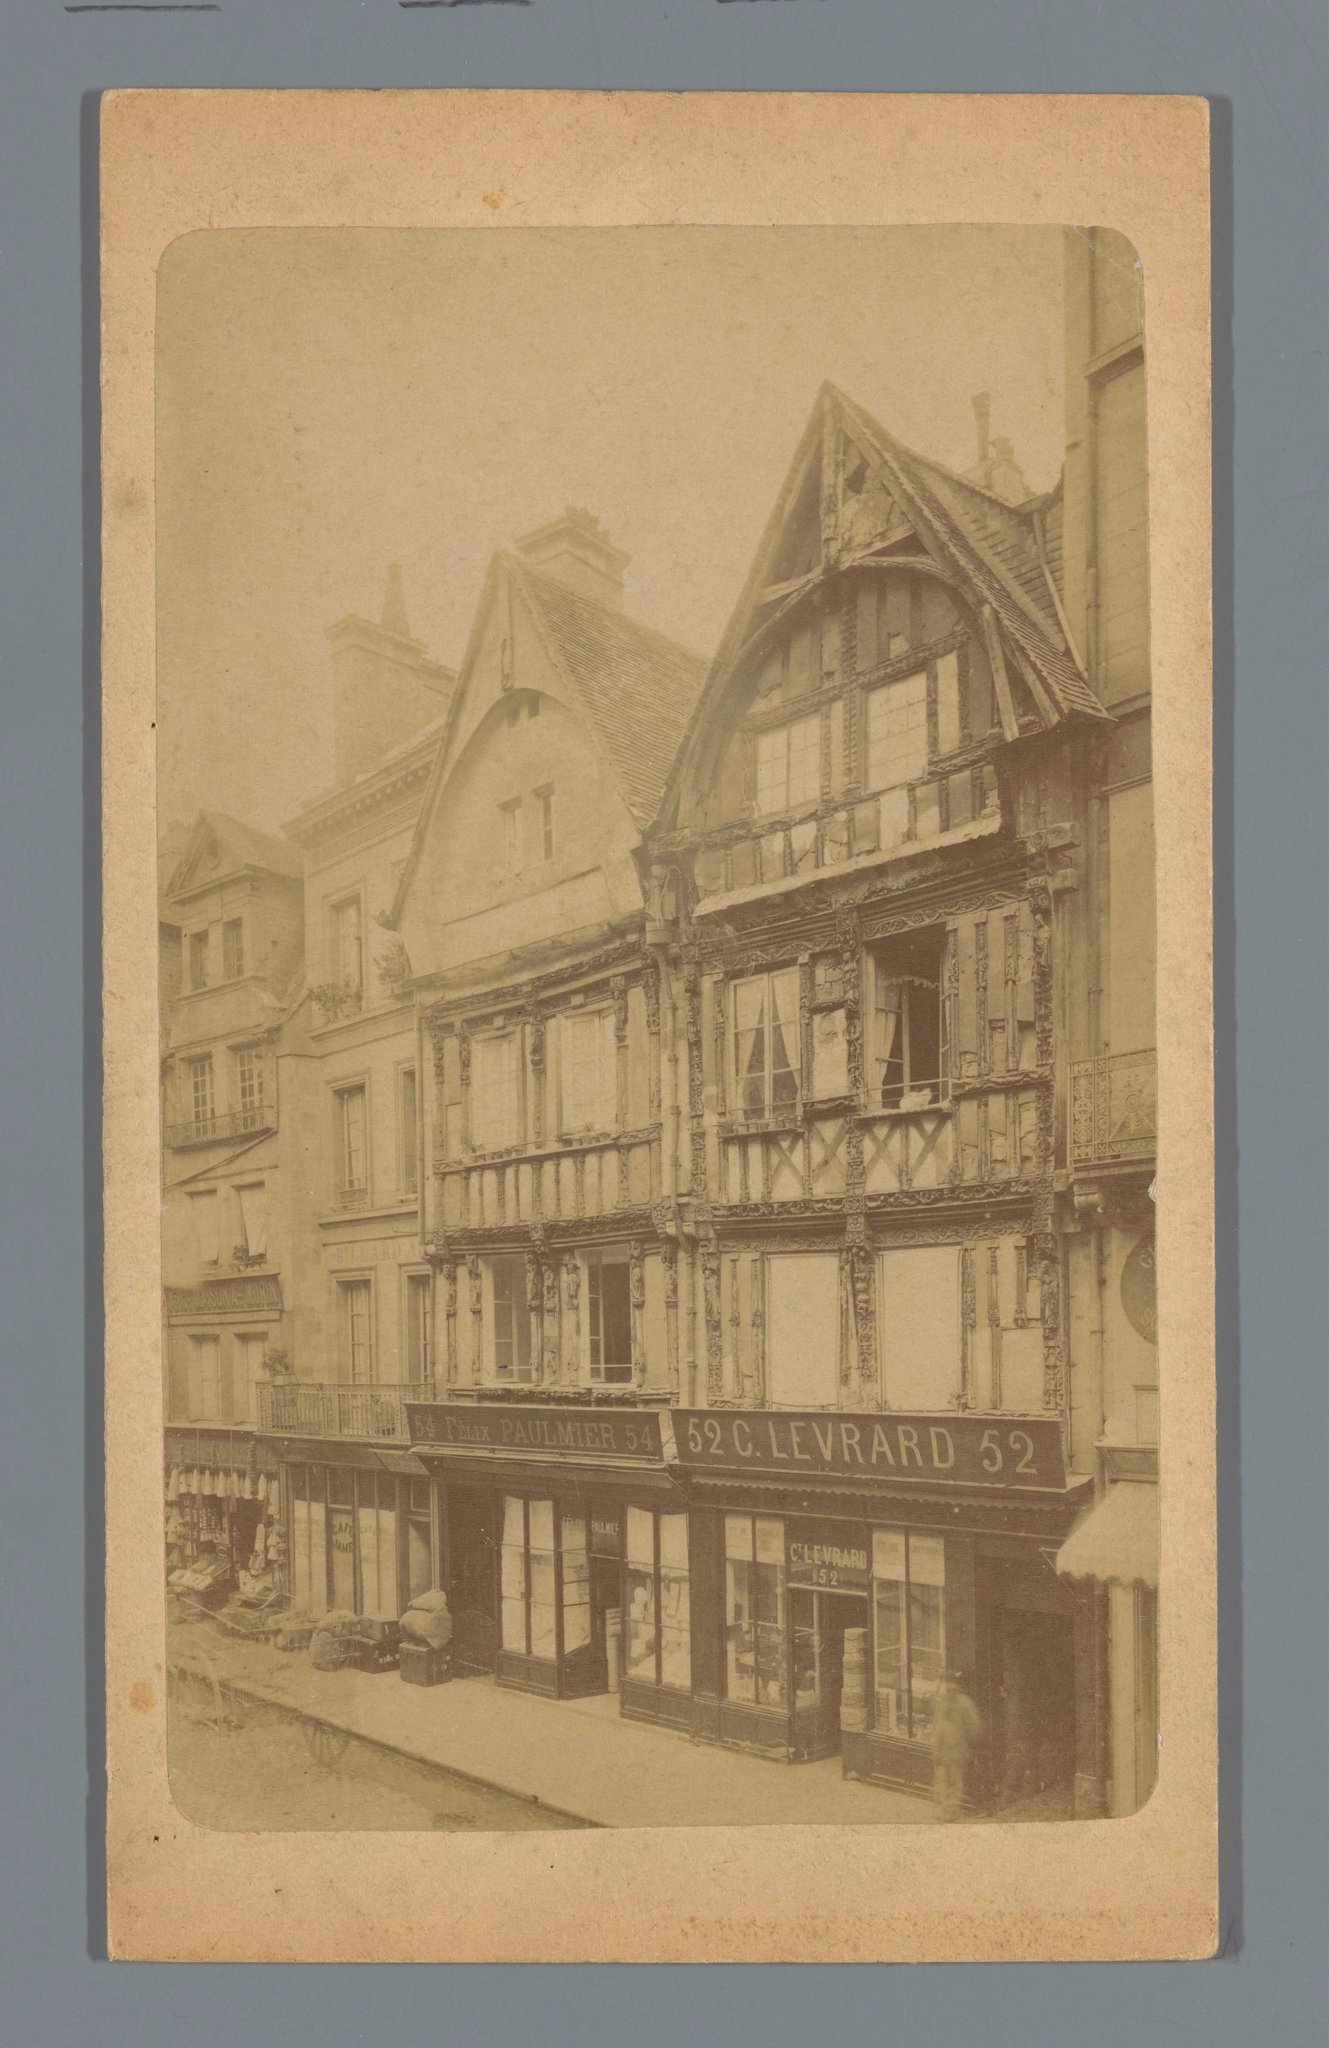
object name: photograph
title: Oude vakwerkhuizen in een Zwitserse stad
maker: Anonymous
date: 1850-1900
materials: cardboard, photographic support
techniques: albumen print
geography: switzerland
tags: housing, shop-window, show-window, switzerland